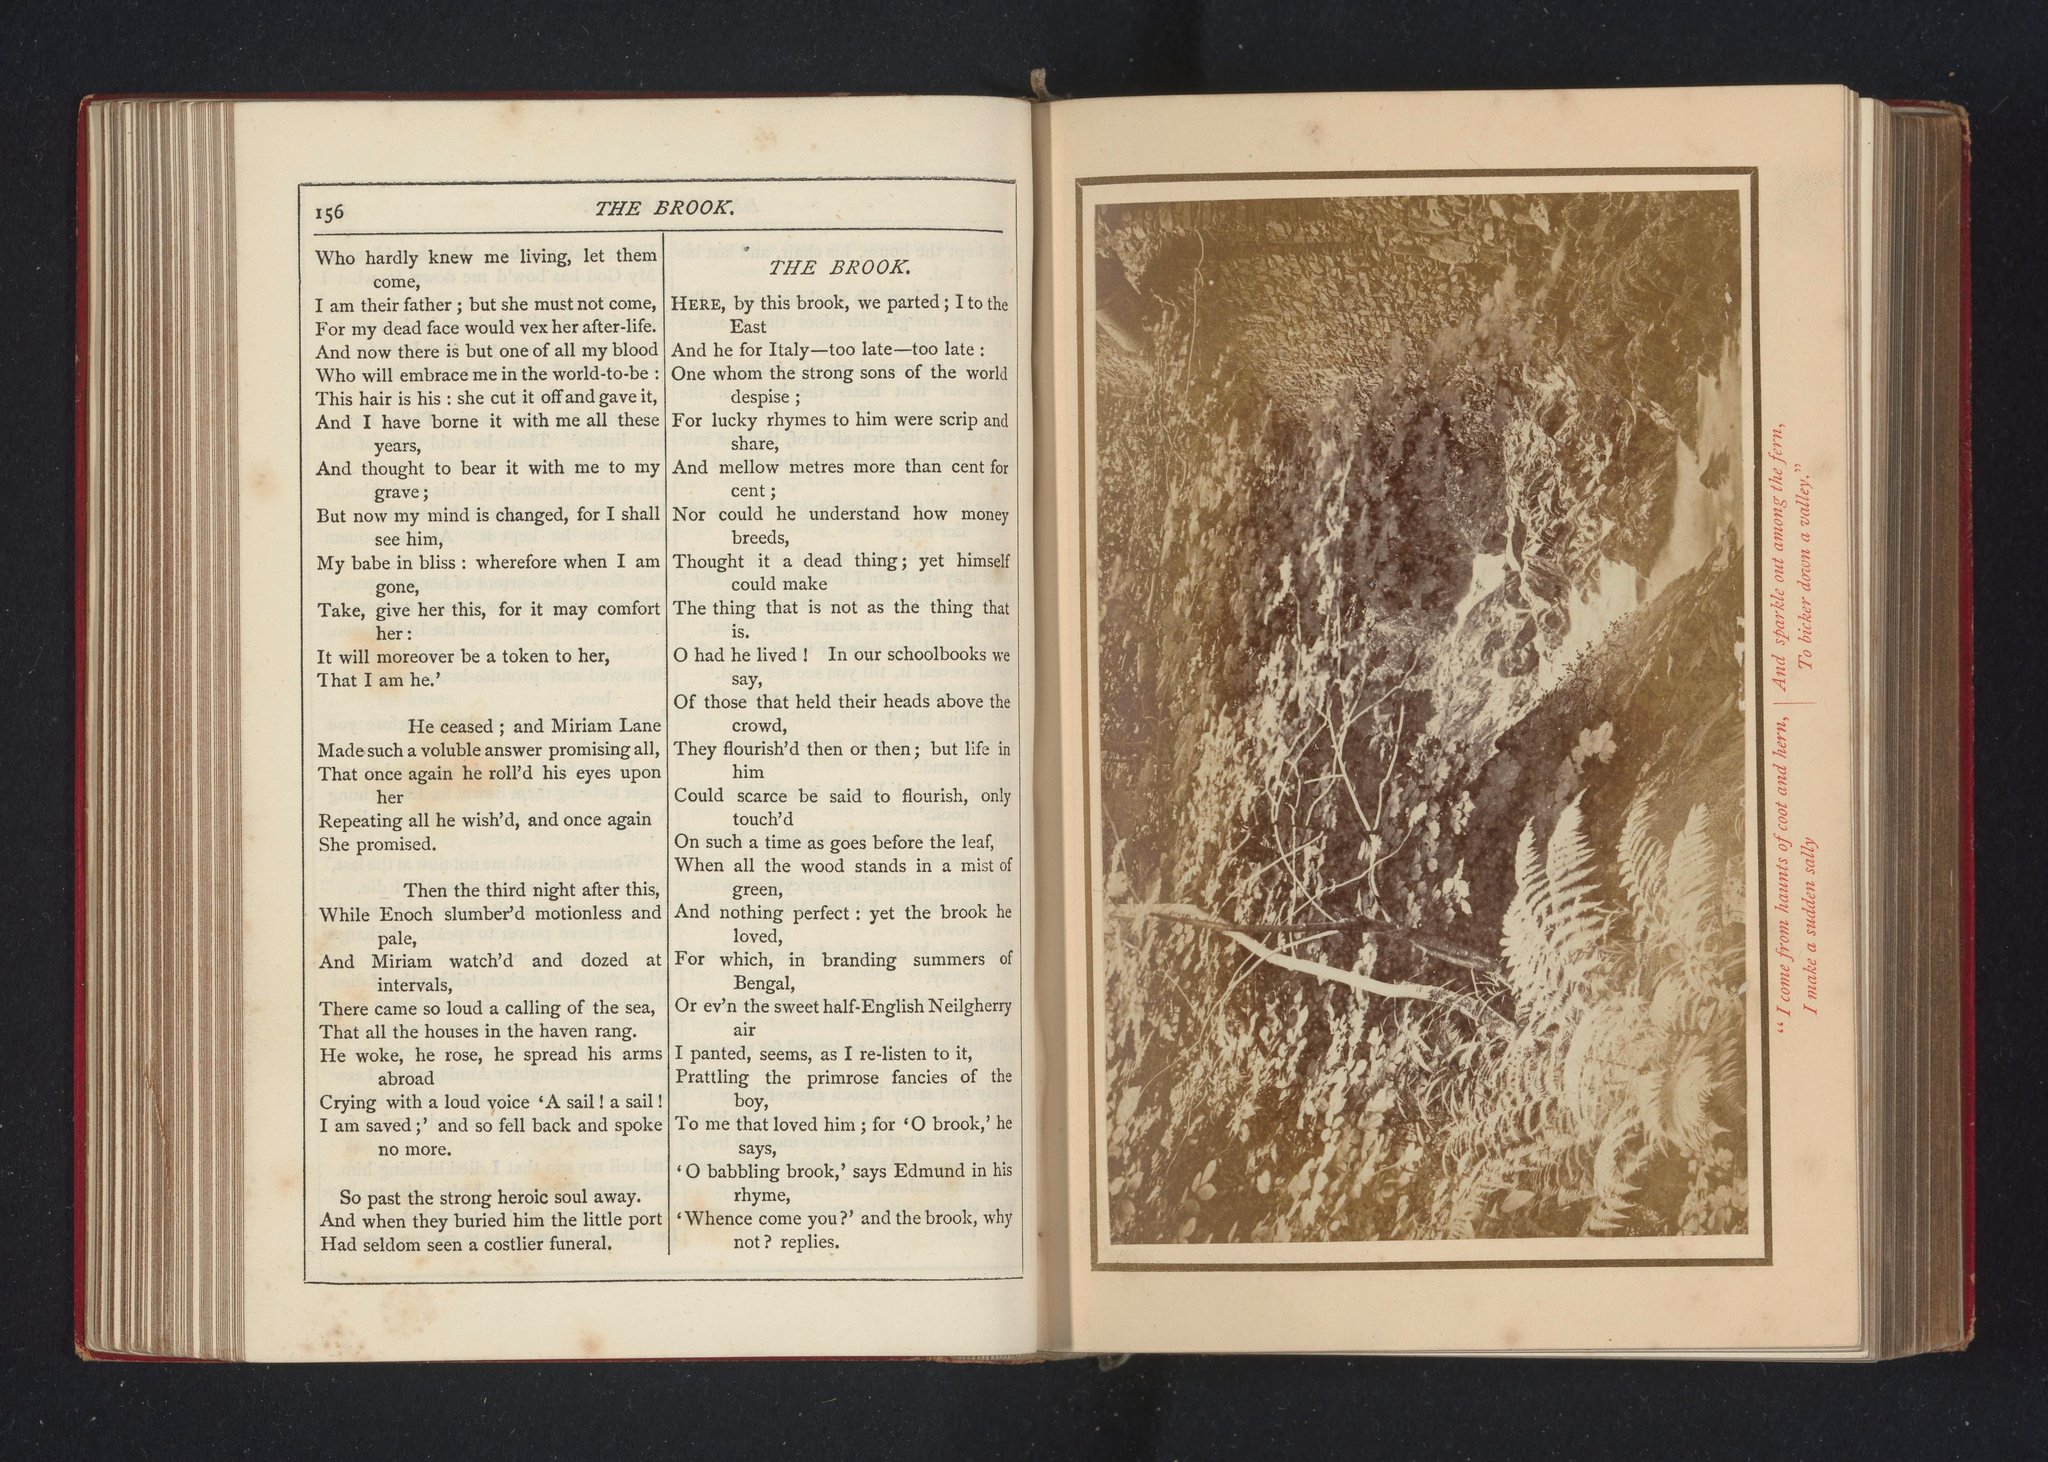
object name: photograph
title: Struiken langs een beek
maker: john payne jennings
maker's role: fotograaf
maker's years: 1843-1926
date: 1873-1878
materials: photographic support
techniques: albumen print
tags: ferns, brook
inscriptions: inscription: ‘"I come from haunts of coot and hern, I make a sudden sally And spearkle out among the fern, To bicker down a valley"’